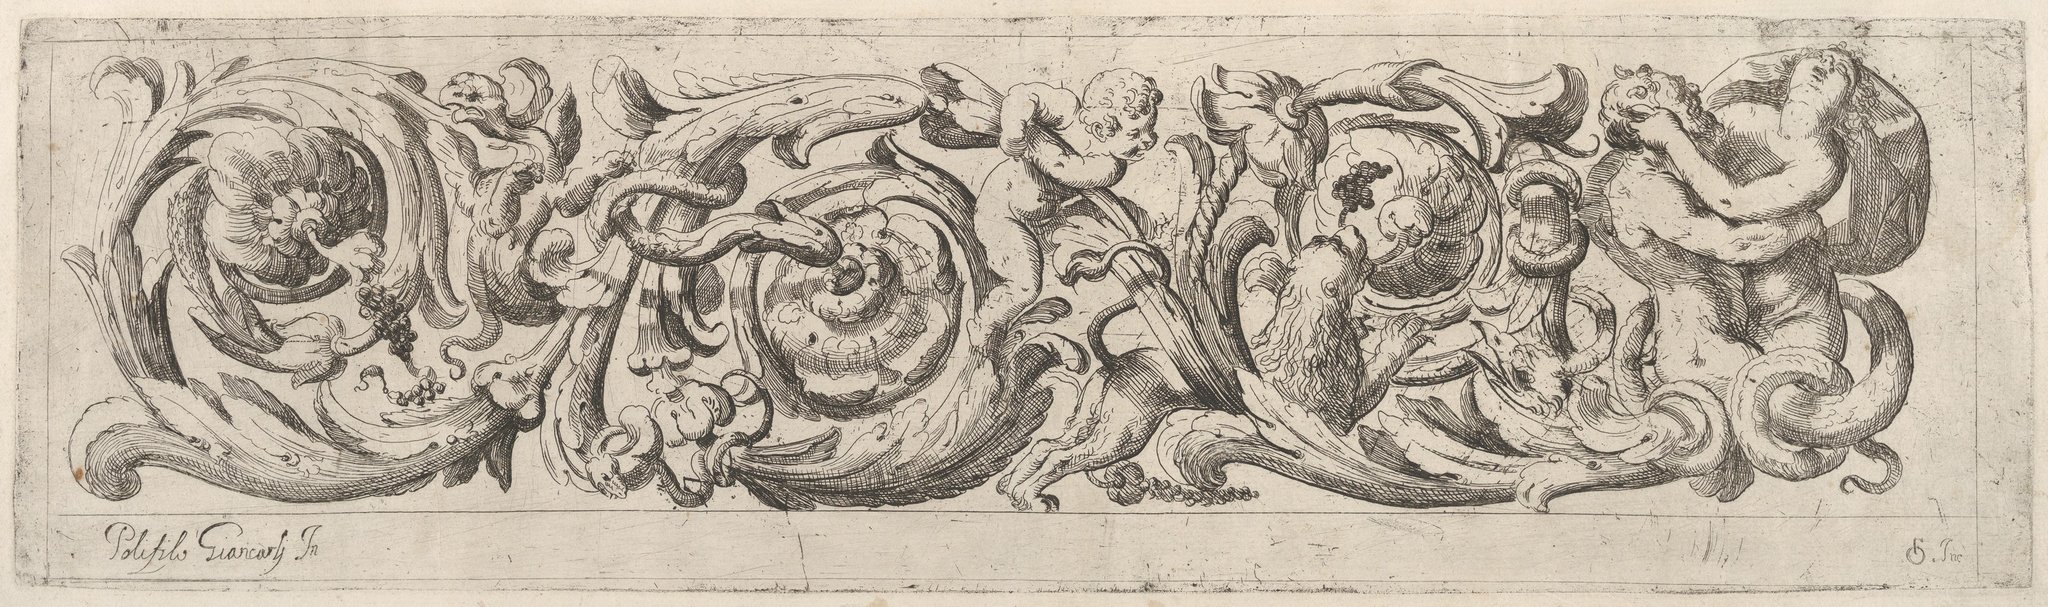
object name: collection ornament architecture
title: Disegni Varij di Polifilo Zancarli (Friezes)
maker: polifilo giancarli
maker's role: artist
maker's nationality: italian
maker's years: 1600-1625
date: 1625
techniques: etching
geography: italy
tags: ornament,griffins,putti,satyrs,lions